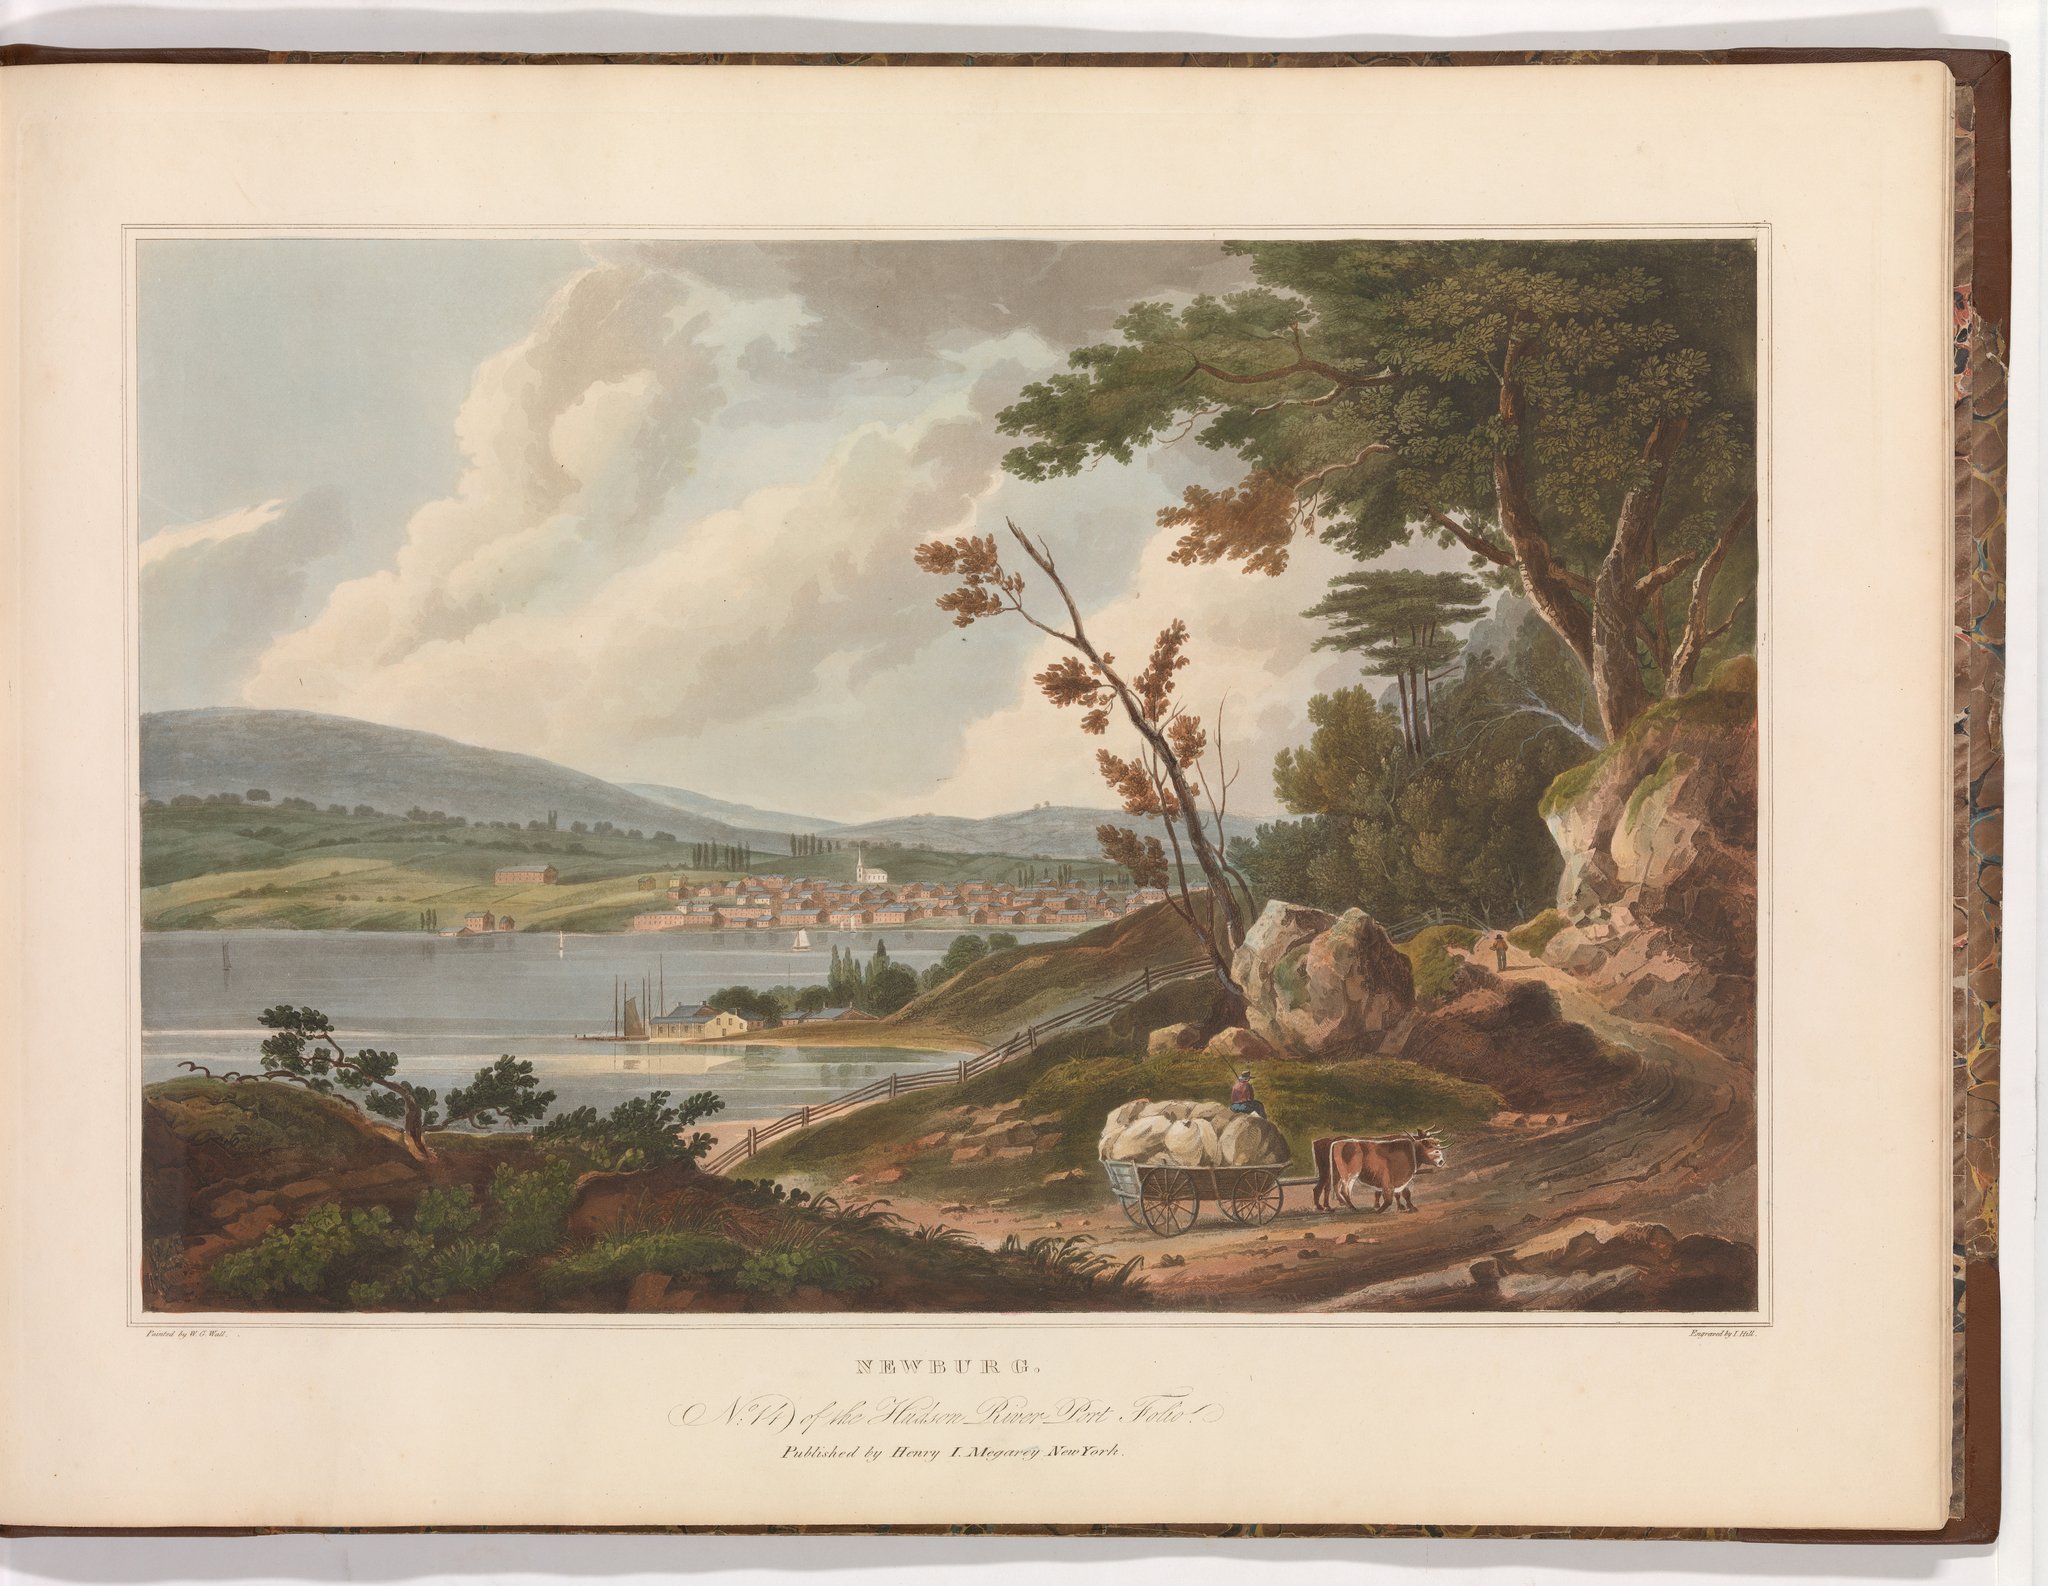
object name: print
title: Newburg [Newburgh] (No. 14 of The Hudson River Portfolio)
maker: john hill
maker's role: etcher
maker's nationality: american, born england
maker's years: 1770-1850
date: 1825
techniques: aquatint, hand coloring, printing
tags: men,bulls,rivers,landscapes,carriages